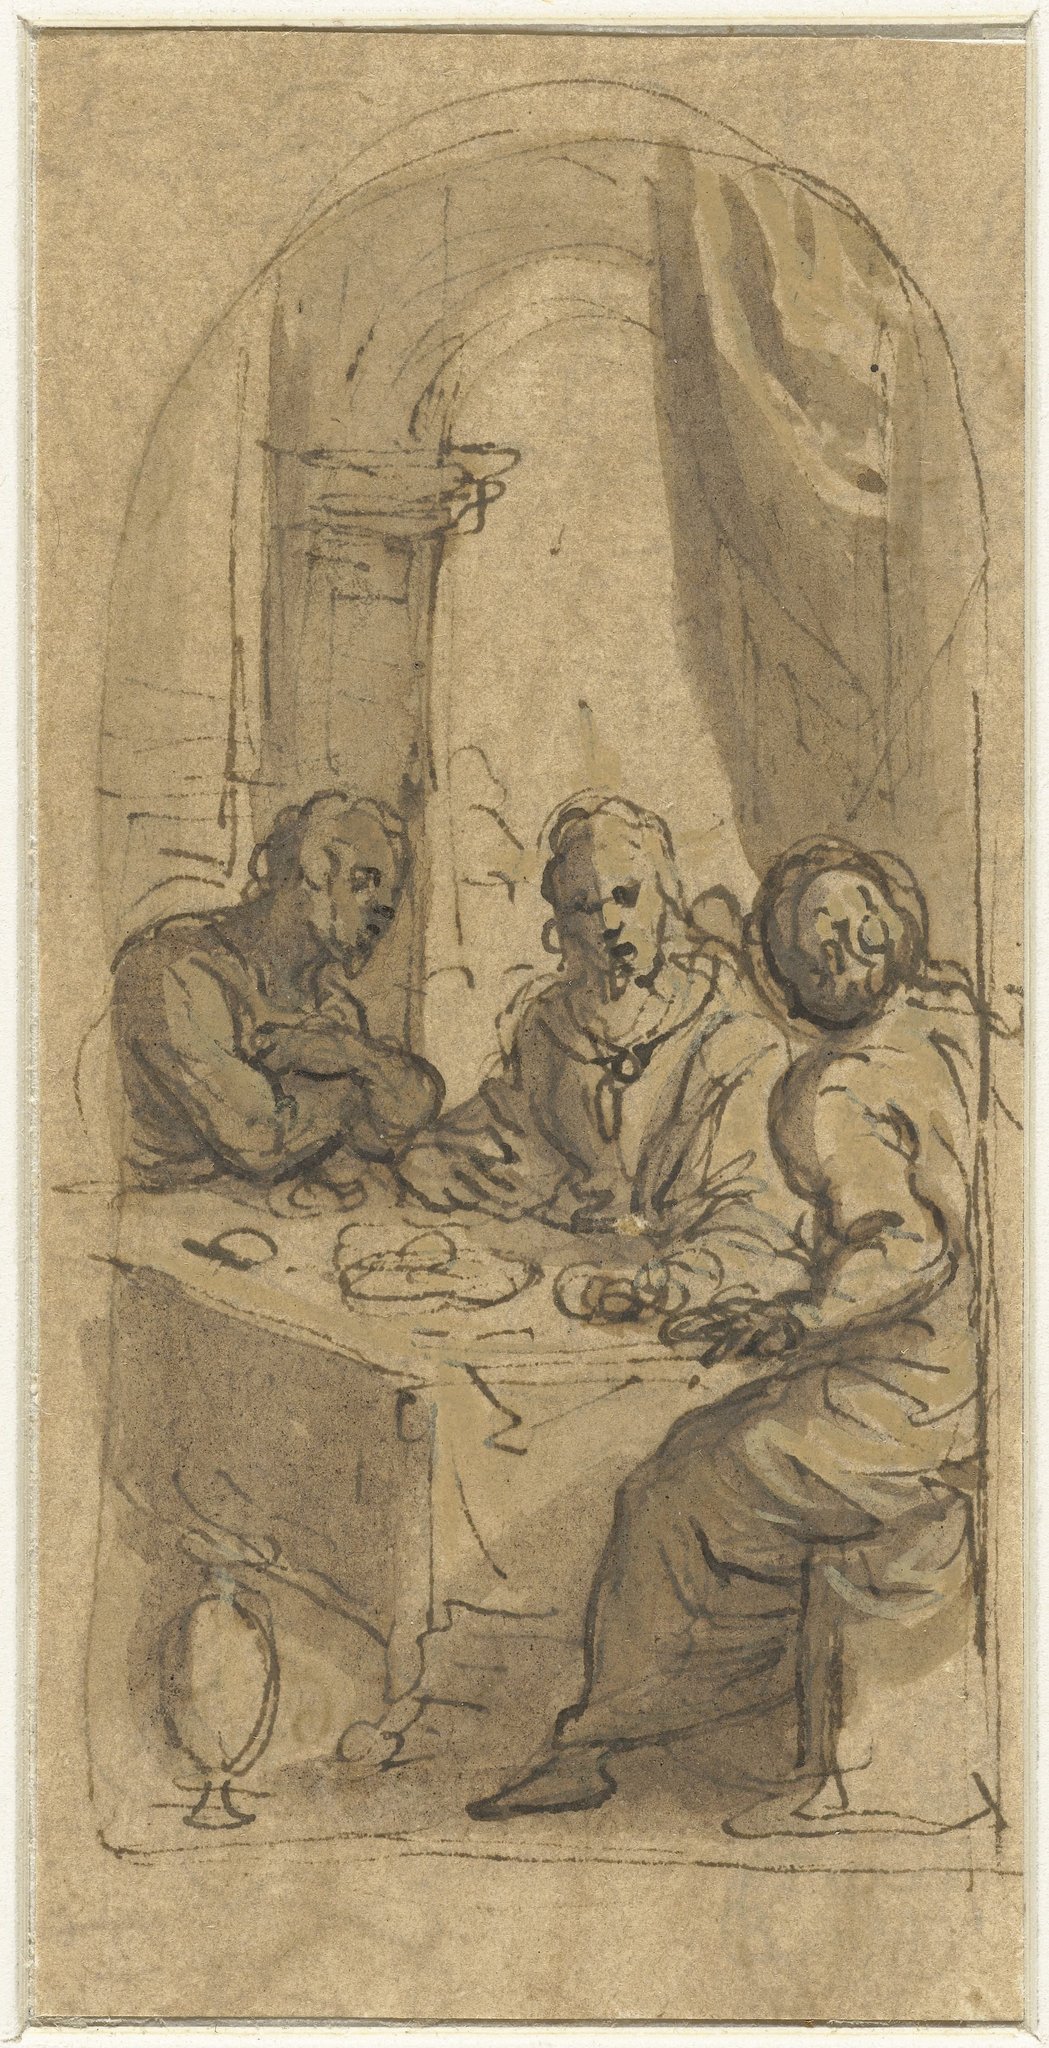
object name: drawing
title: De Emmaüsgangers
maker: jacopo palma (il giovane)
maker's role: draughtsman, painter, print maker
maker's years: 1544-1628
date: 1554-1628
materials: ink, paper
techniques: brush, pen